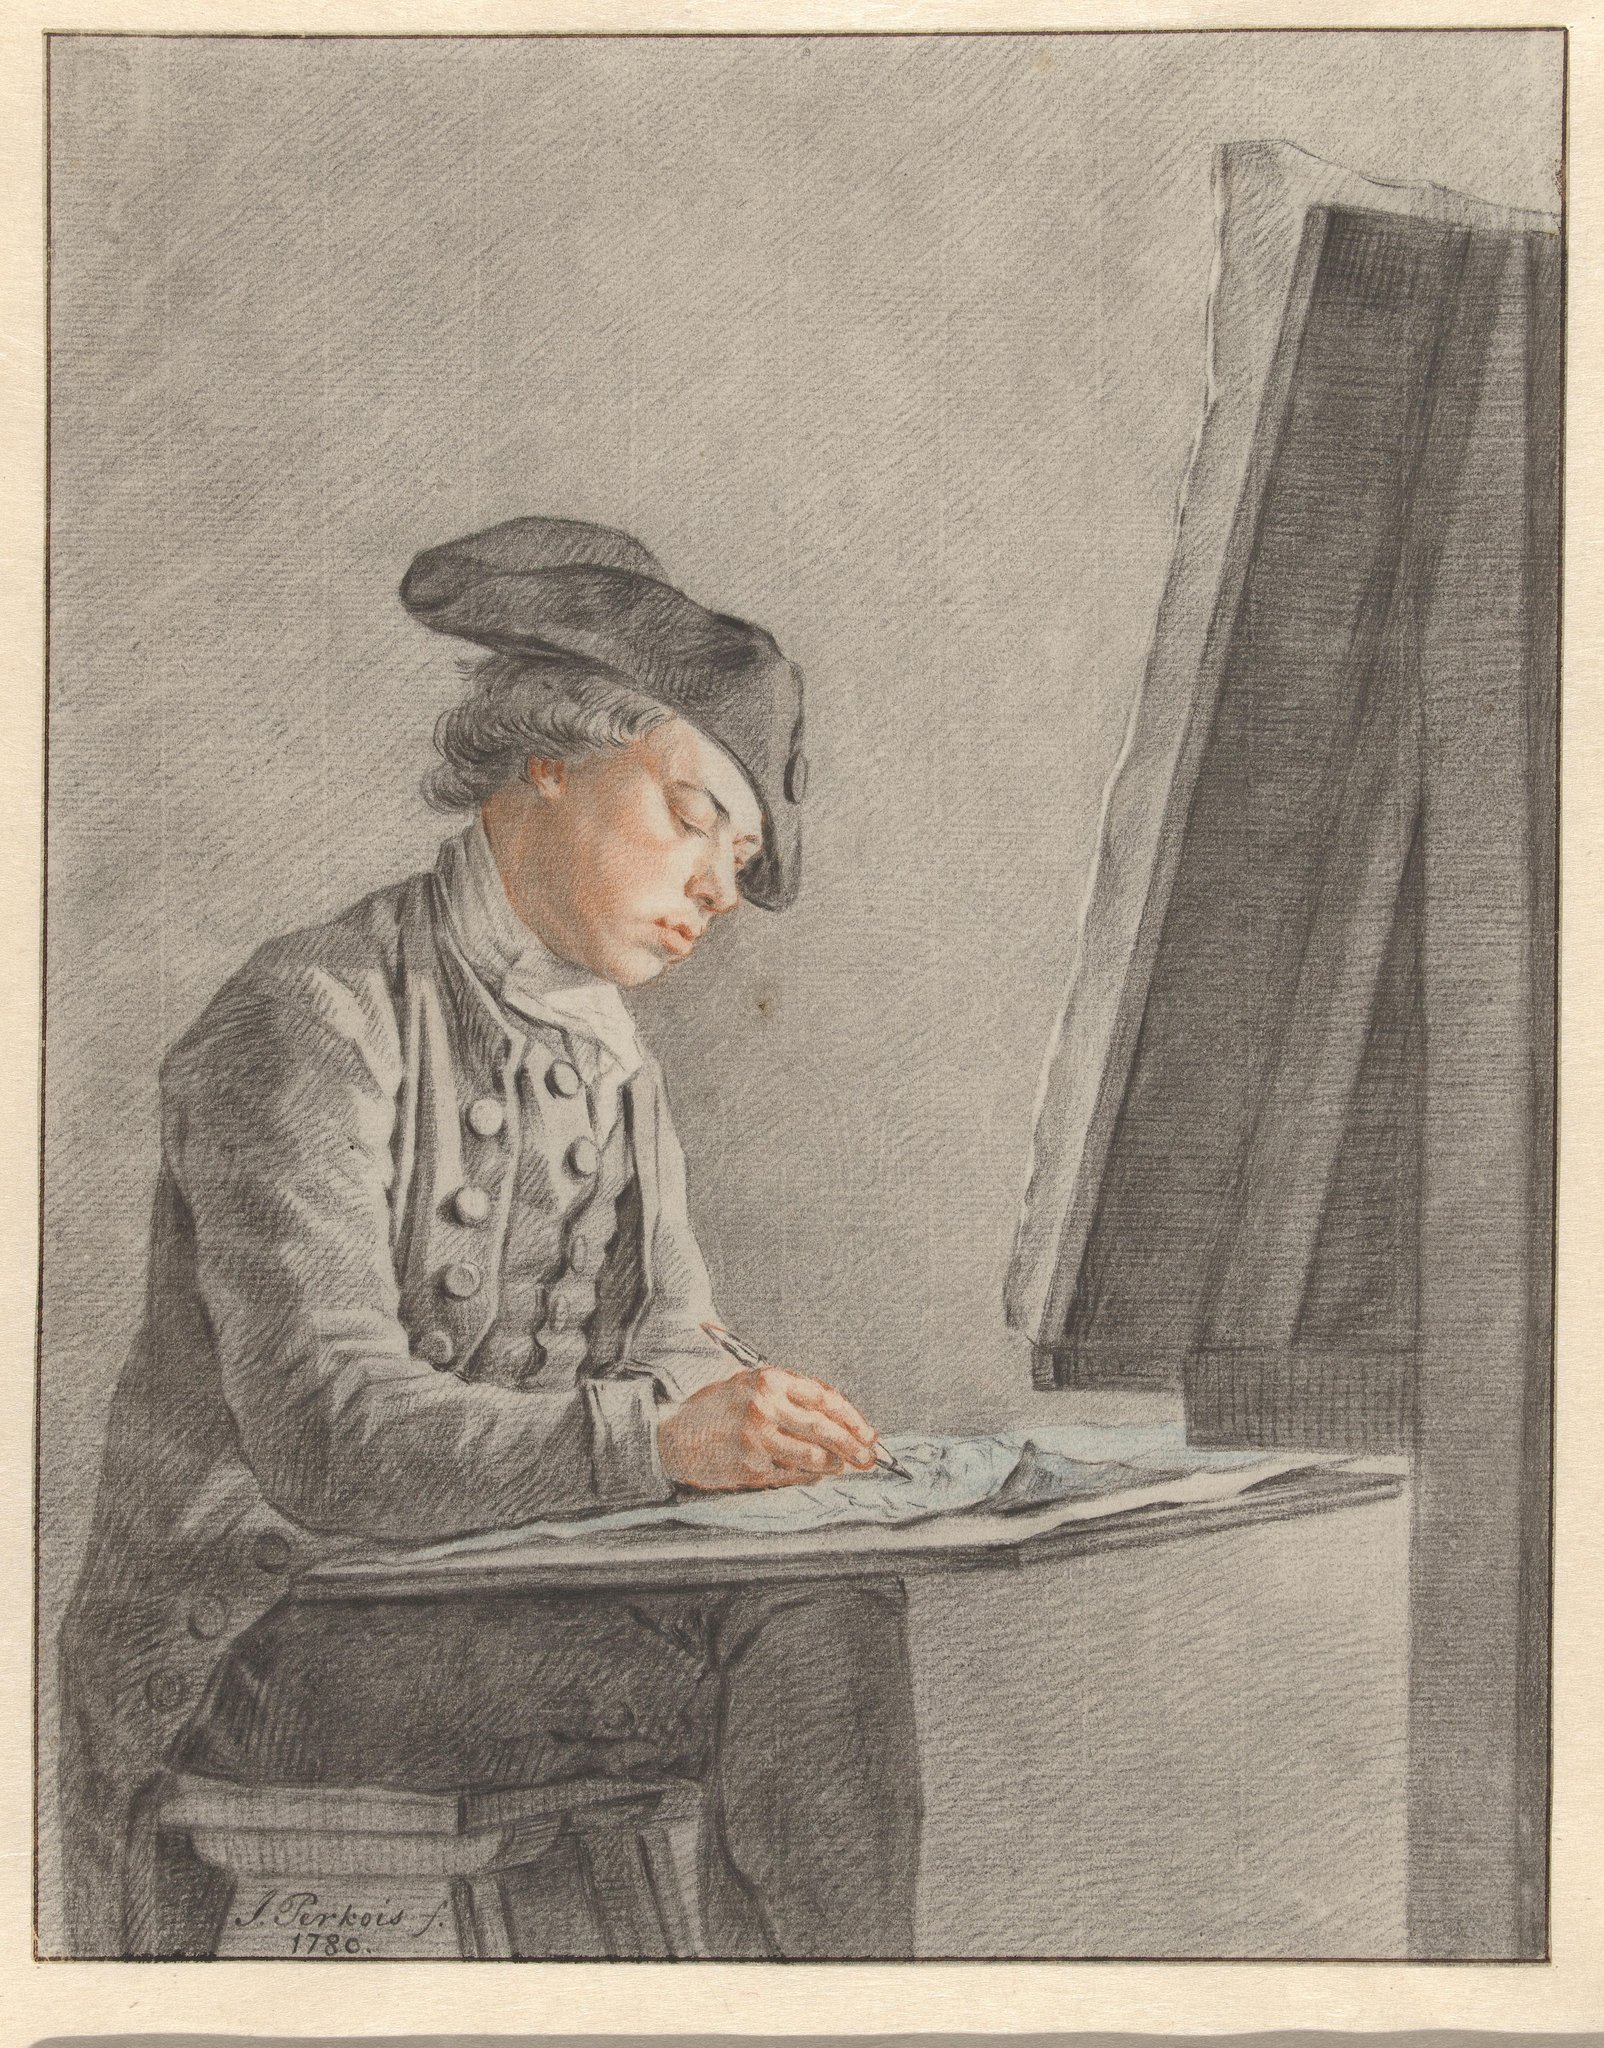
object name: drawing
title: Zelfportret van Jacob Perkois, tekenend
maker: jacob perkois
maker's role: draughtsman, print maker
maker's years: 1756-1804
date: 1780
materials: chalk, paper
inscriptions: date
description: Zelfportret van Jacob Perkois, drievierde naar rechts, op een bank gezeten. Hij houdt een tekenplank op de knieën en een tekenpen in de rechterhand. Rechts staat een schildersezel.